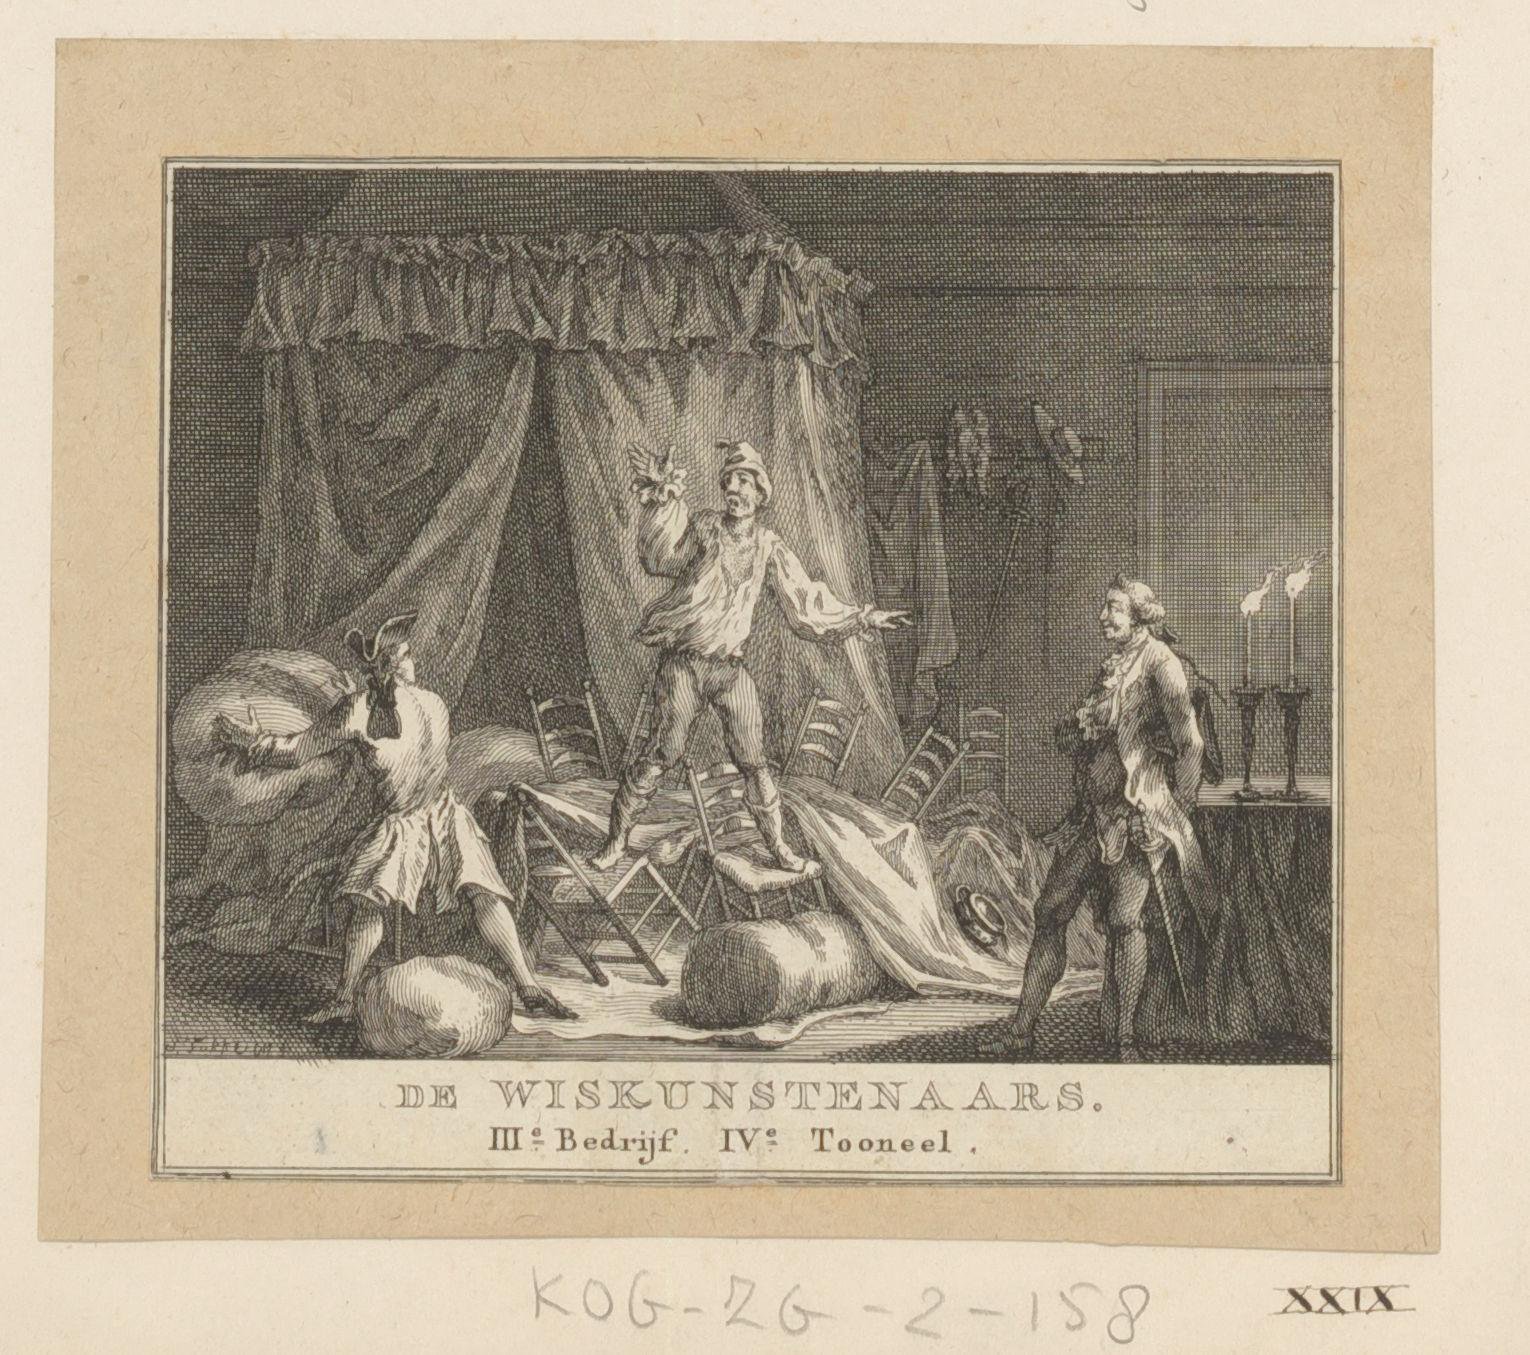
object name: print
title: De Wiskunstenaars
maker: simon fokke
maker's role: draughtsman, print maker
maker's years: 1712-1784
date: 1760-1799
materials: paper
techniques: etching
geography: netherlands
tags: comedy, bedroom, underclothes and nightwear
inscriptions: collector's mark: Lugt 2488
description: In een slaapvertrek balanceert een man in nachtkleding op twee stoelen. Rechts kijkt een heer lachend toe terwijl een tweede heer links de man in nachtkleding probeert te naderen. Deze prent is vervaardigd voor het blijspel "De wiskunstenaars, of ’t Gevluchte juffertje" van Pieter Langendijk. Uit een serie van tien verkleinde latere kopieën, waarschijnlijk uit een almanak. Deze voorstelling is niet door Troost in beeld gebracht, en de prent behoort eigenlijk niet tot de groep van tien anonieme kopieën, maar is wel opgezet op hetzelfde blad als de andere prenten in de serie.